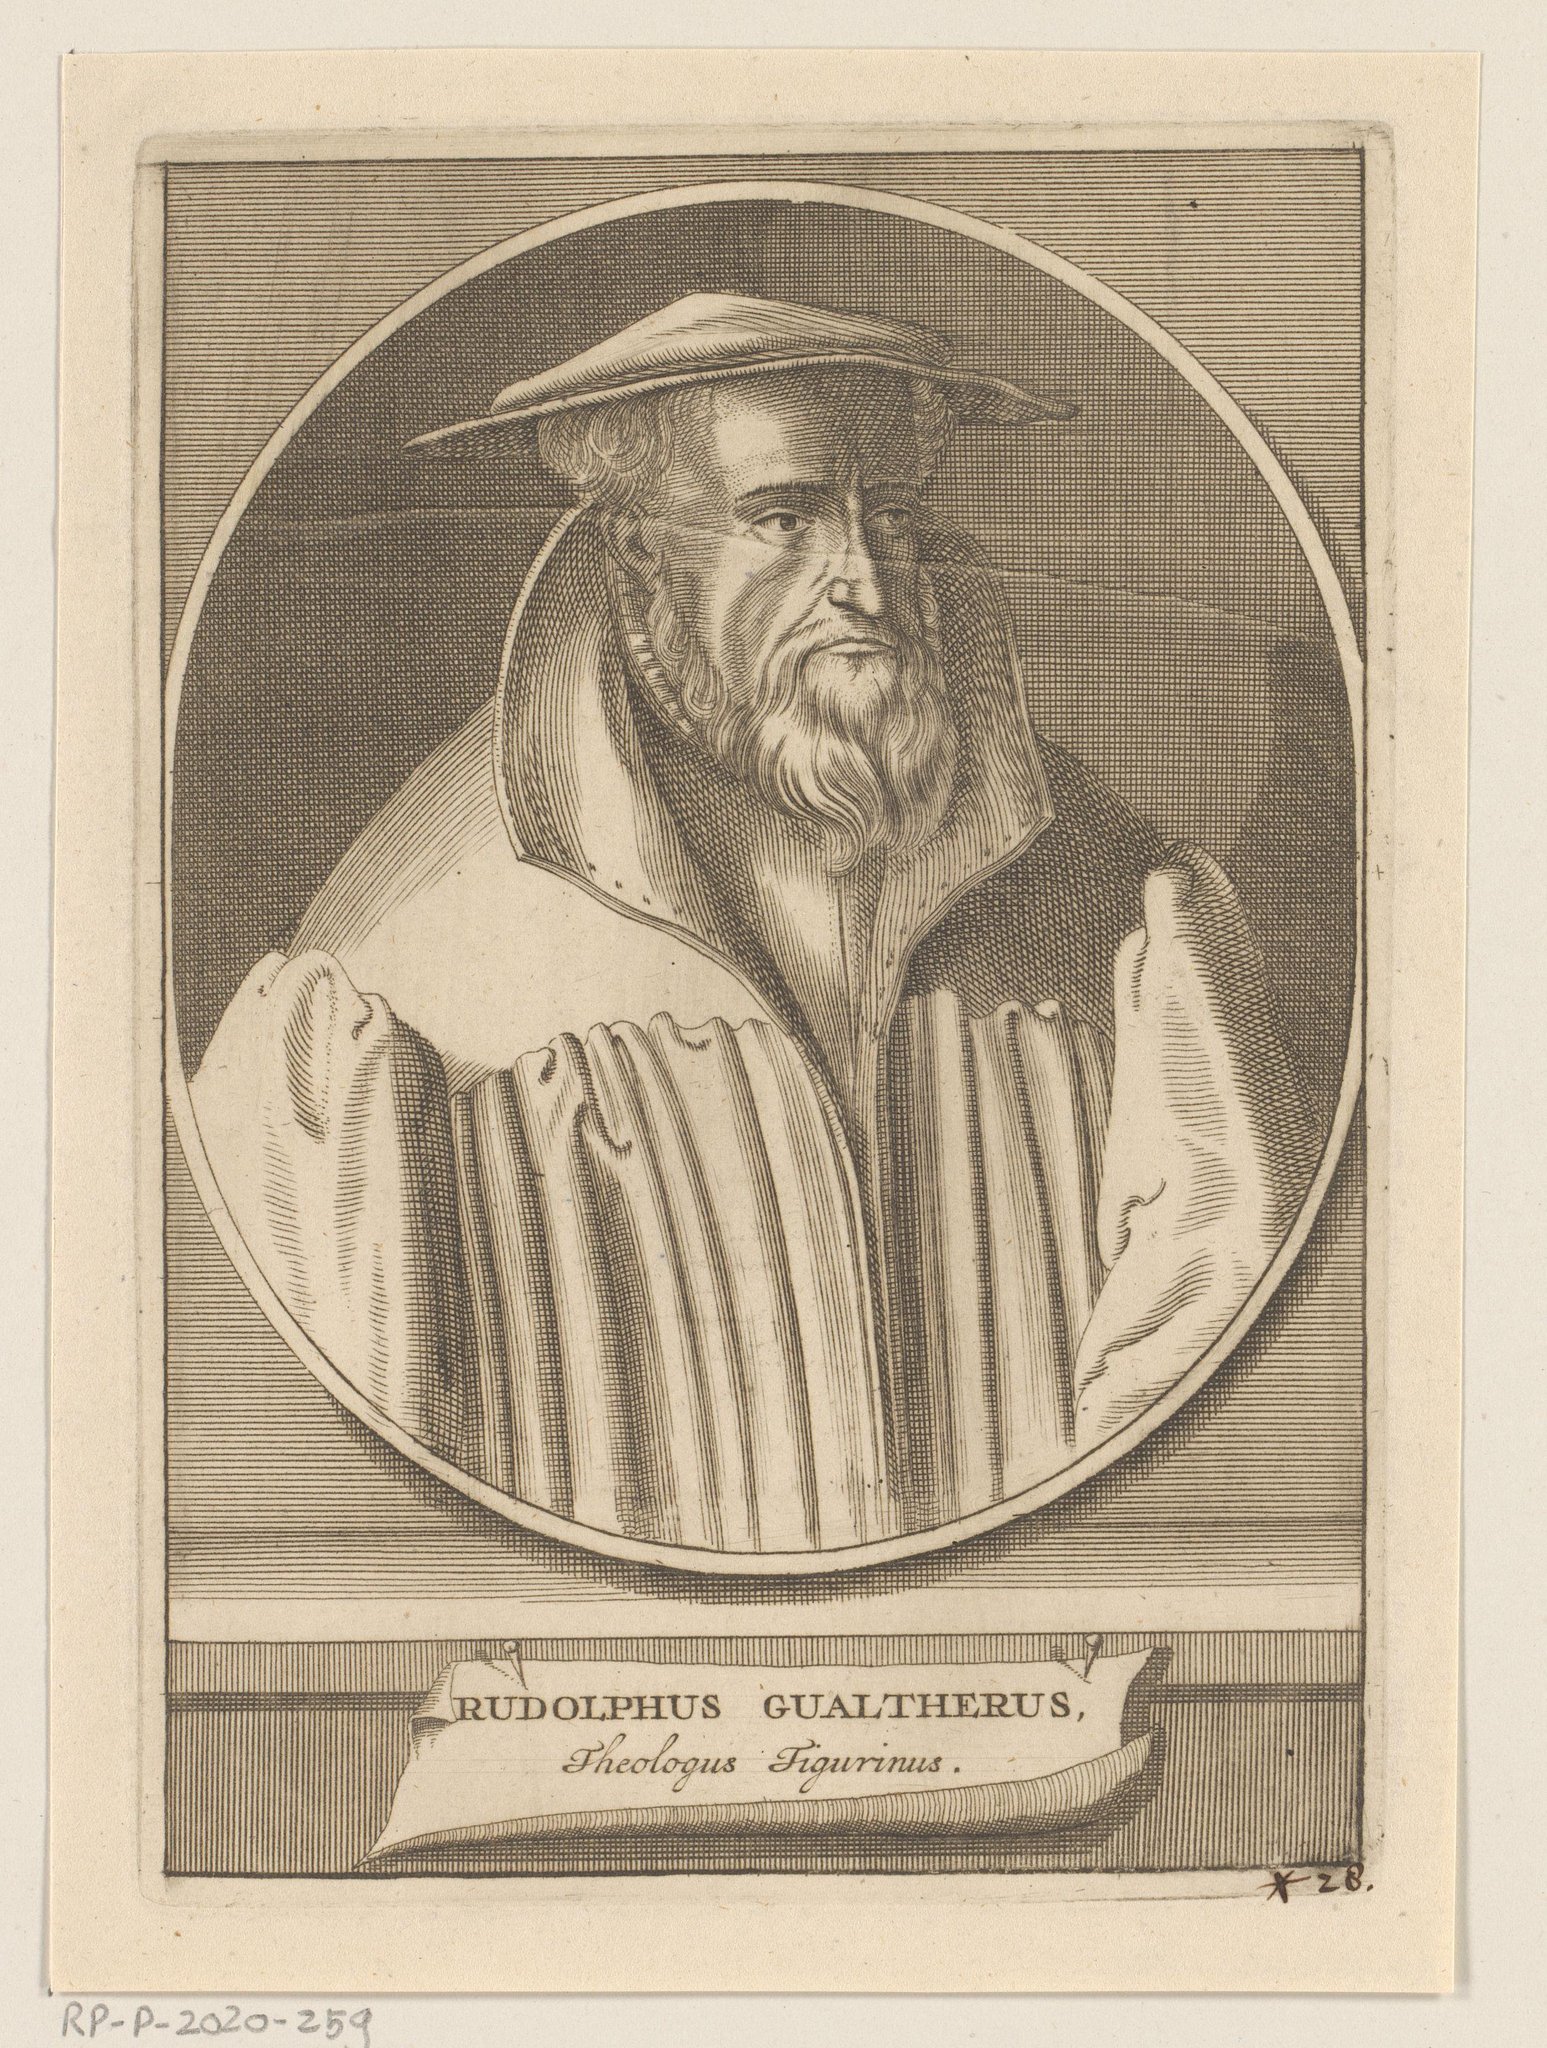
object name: print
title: Portret van Rudolph Gwalther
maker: Anonymous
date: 1600-1699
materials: paper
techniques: engraving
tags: historical persons, functionaries and dignitaries ~ protestant churches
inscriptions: inscription: ‘*28.’